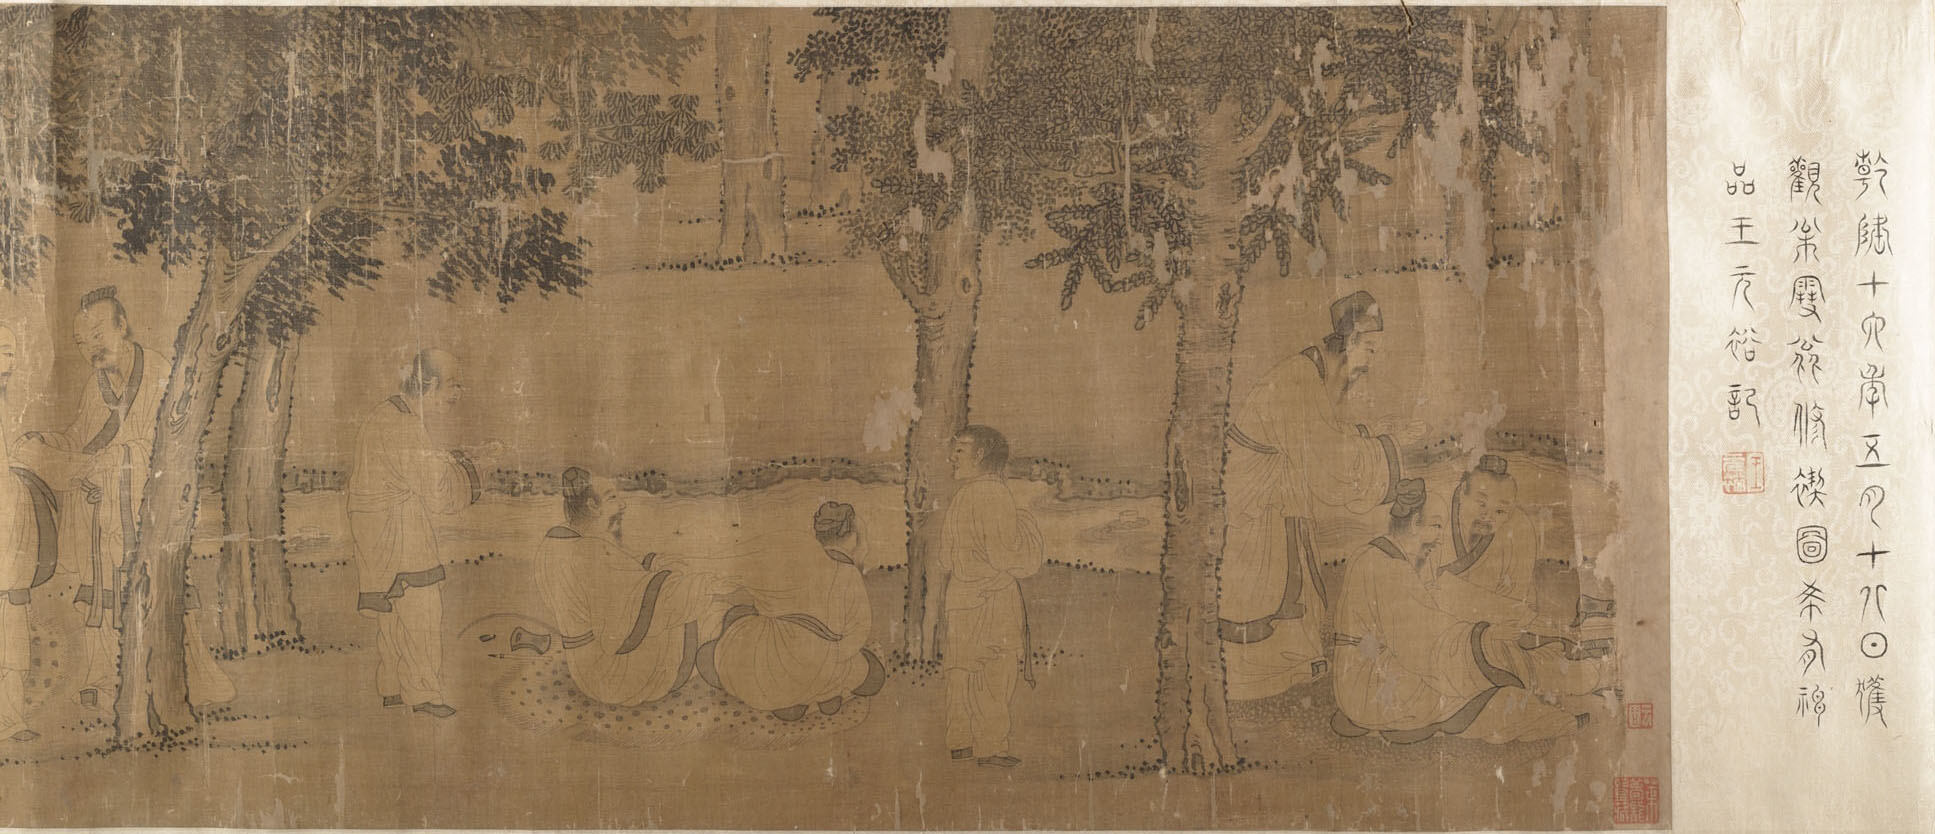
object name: handscroll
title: The Orchid Pavilion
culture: chinese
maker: unidentified artist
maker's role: artist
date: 1368-1911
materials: ink, silk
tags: men,streams